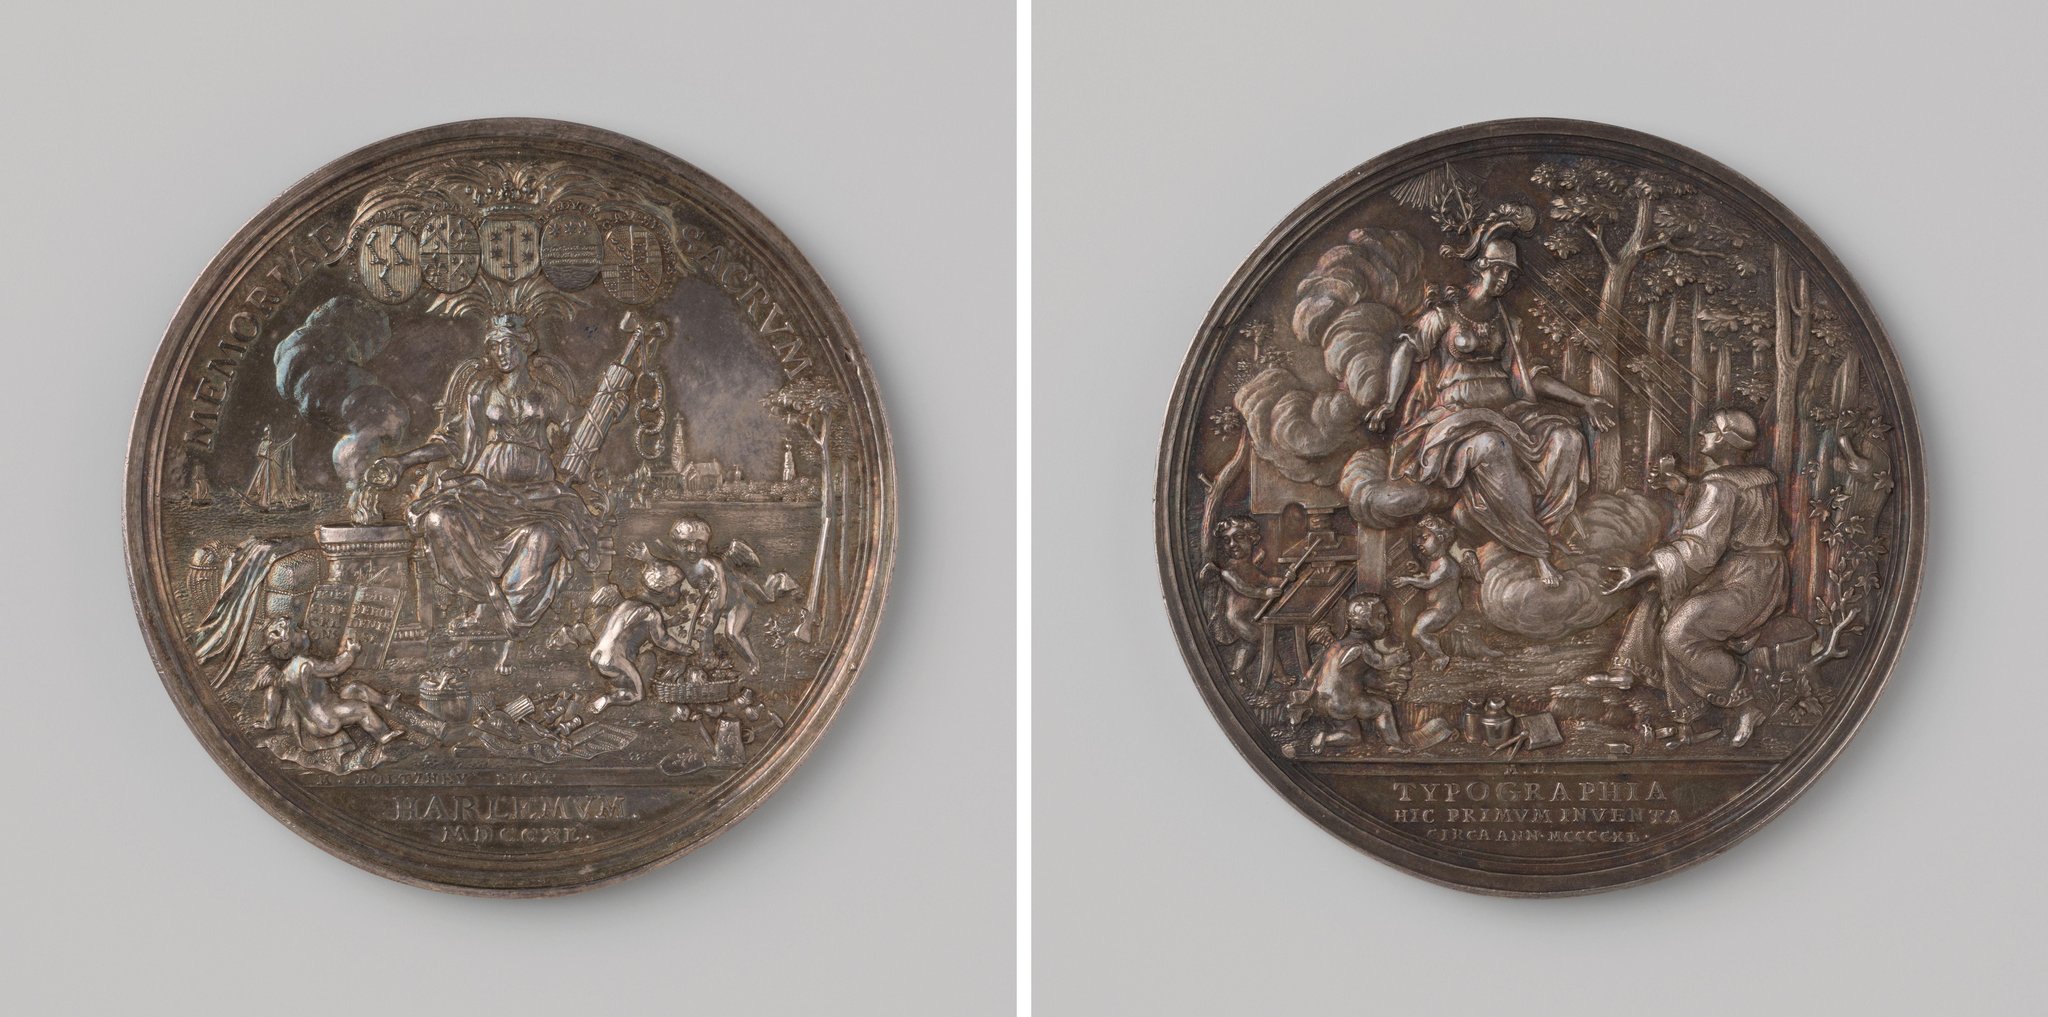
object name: history medal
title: Derde eeuwfeest van de uitvinding van de boekdrukkunst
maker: martinus holtzhey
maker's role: medailleur, muntmaker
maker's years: 1697-1764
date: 1740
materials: silver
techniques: striking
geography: amsterdam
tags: haarlem